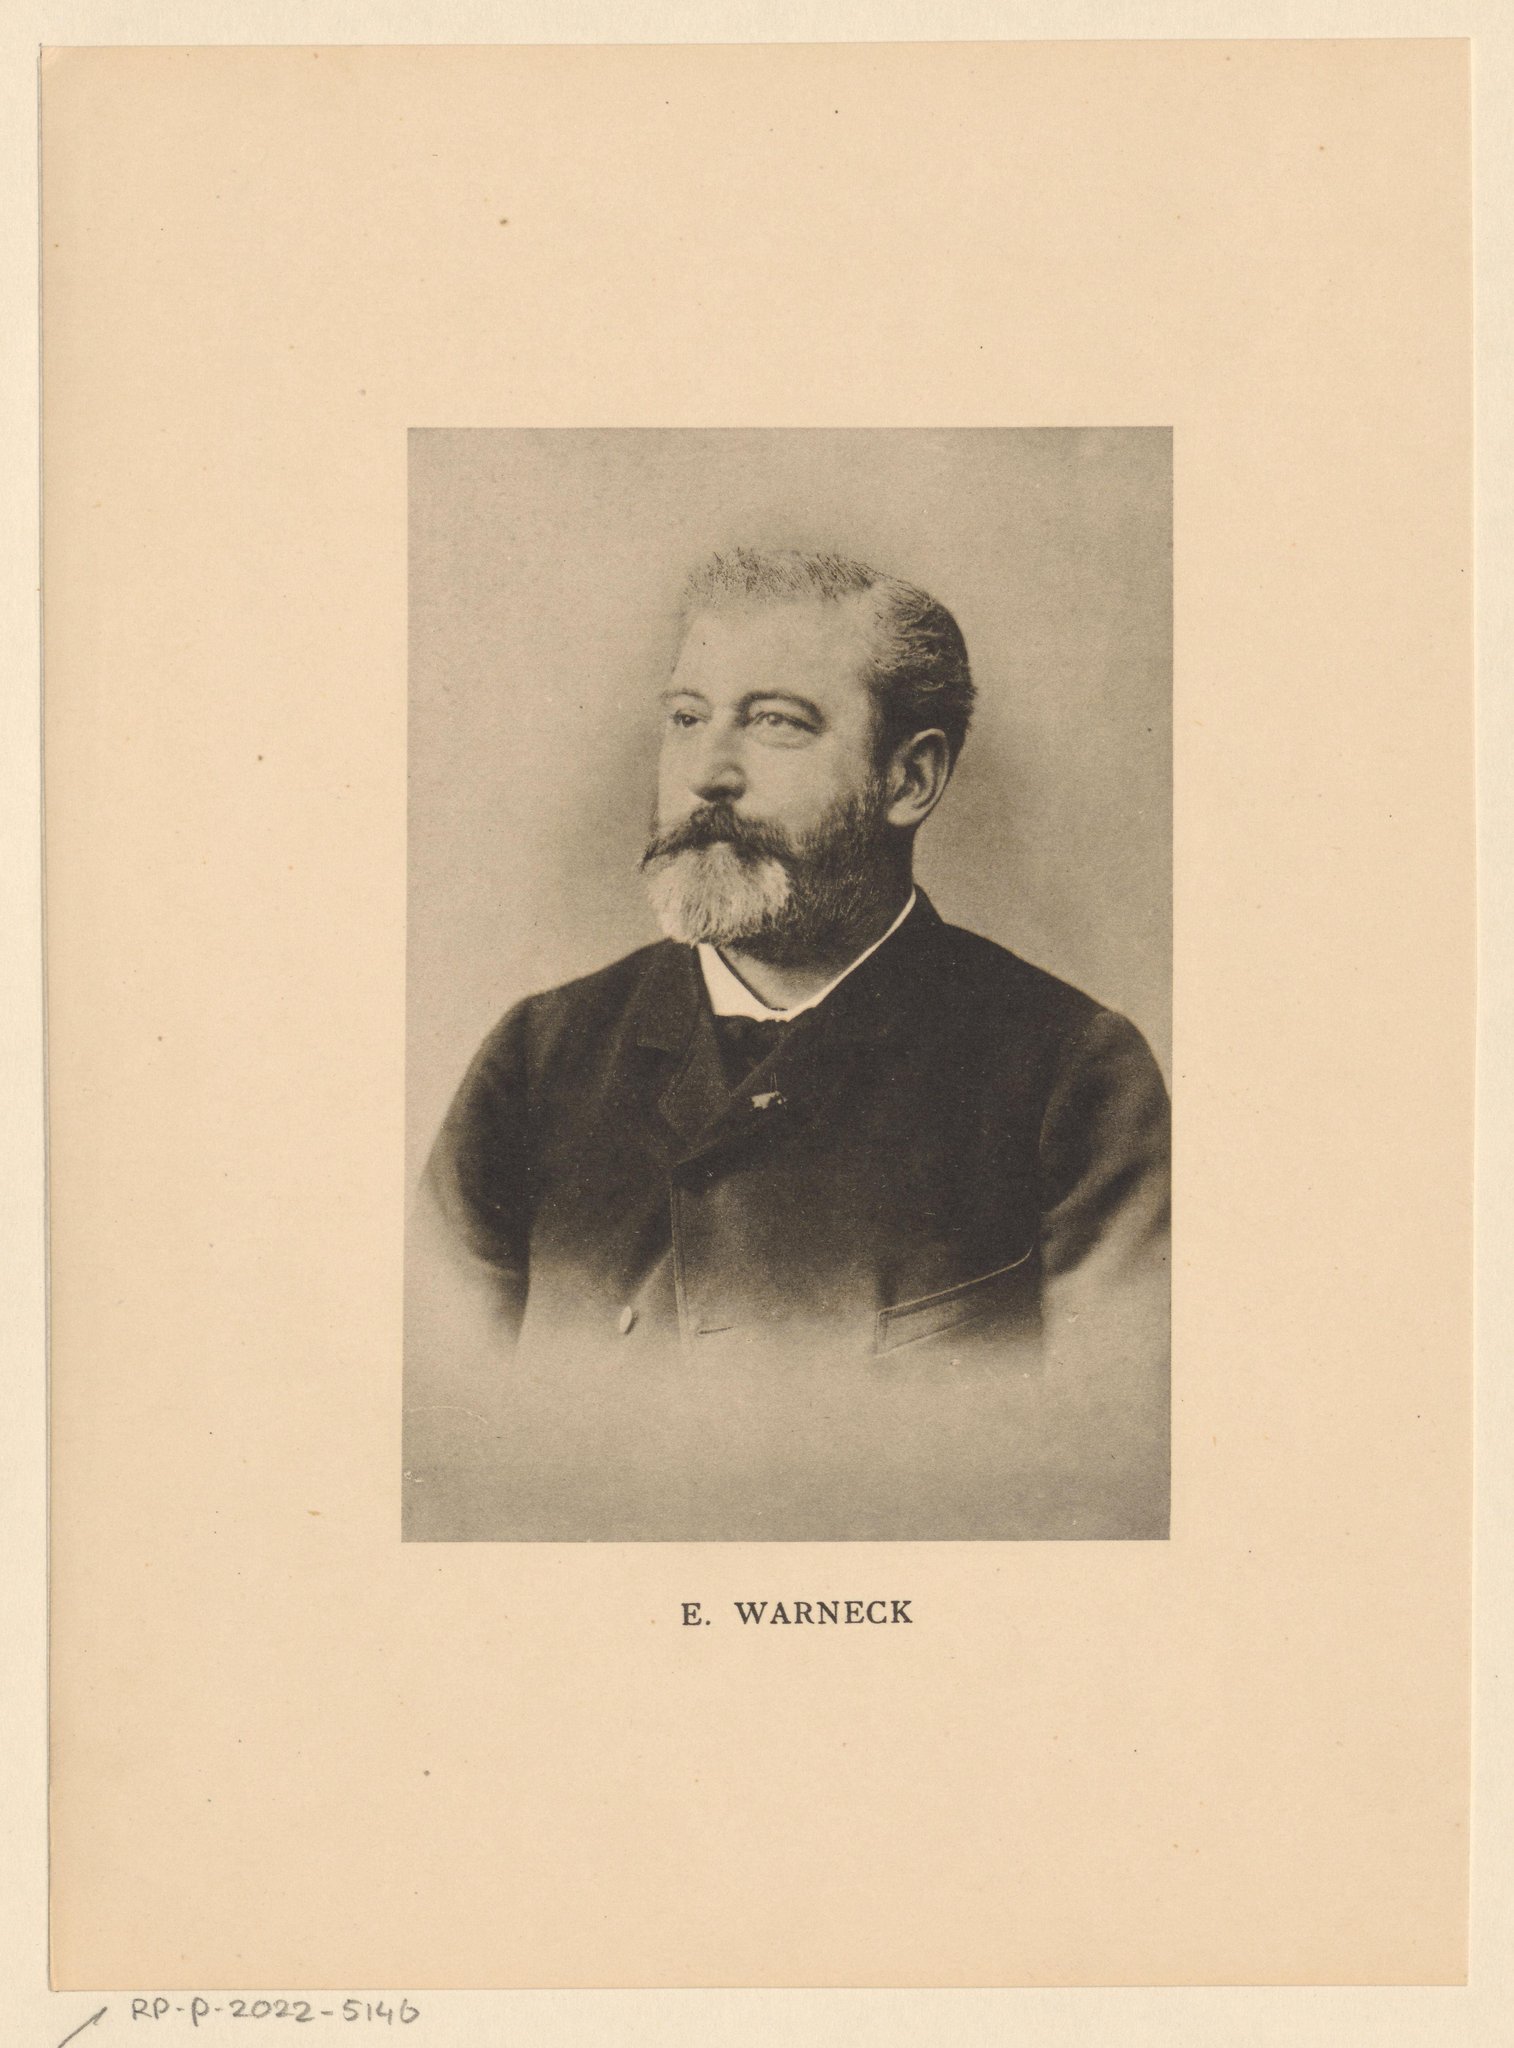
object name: photomechanical print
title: Portret van Edouard Warneck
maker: Anonymous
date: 1875-1930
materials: paper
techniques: photograph, letterpress printing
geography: france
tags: paris, historical persons, art collector, art dealer